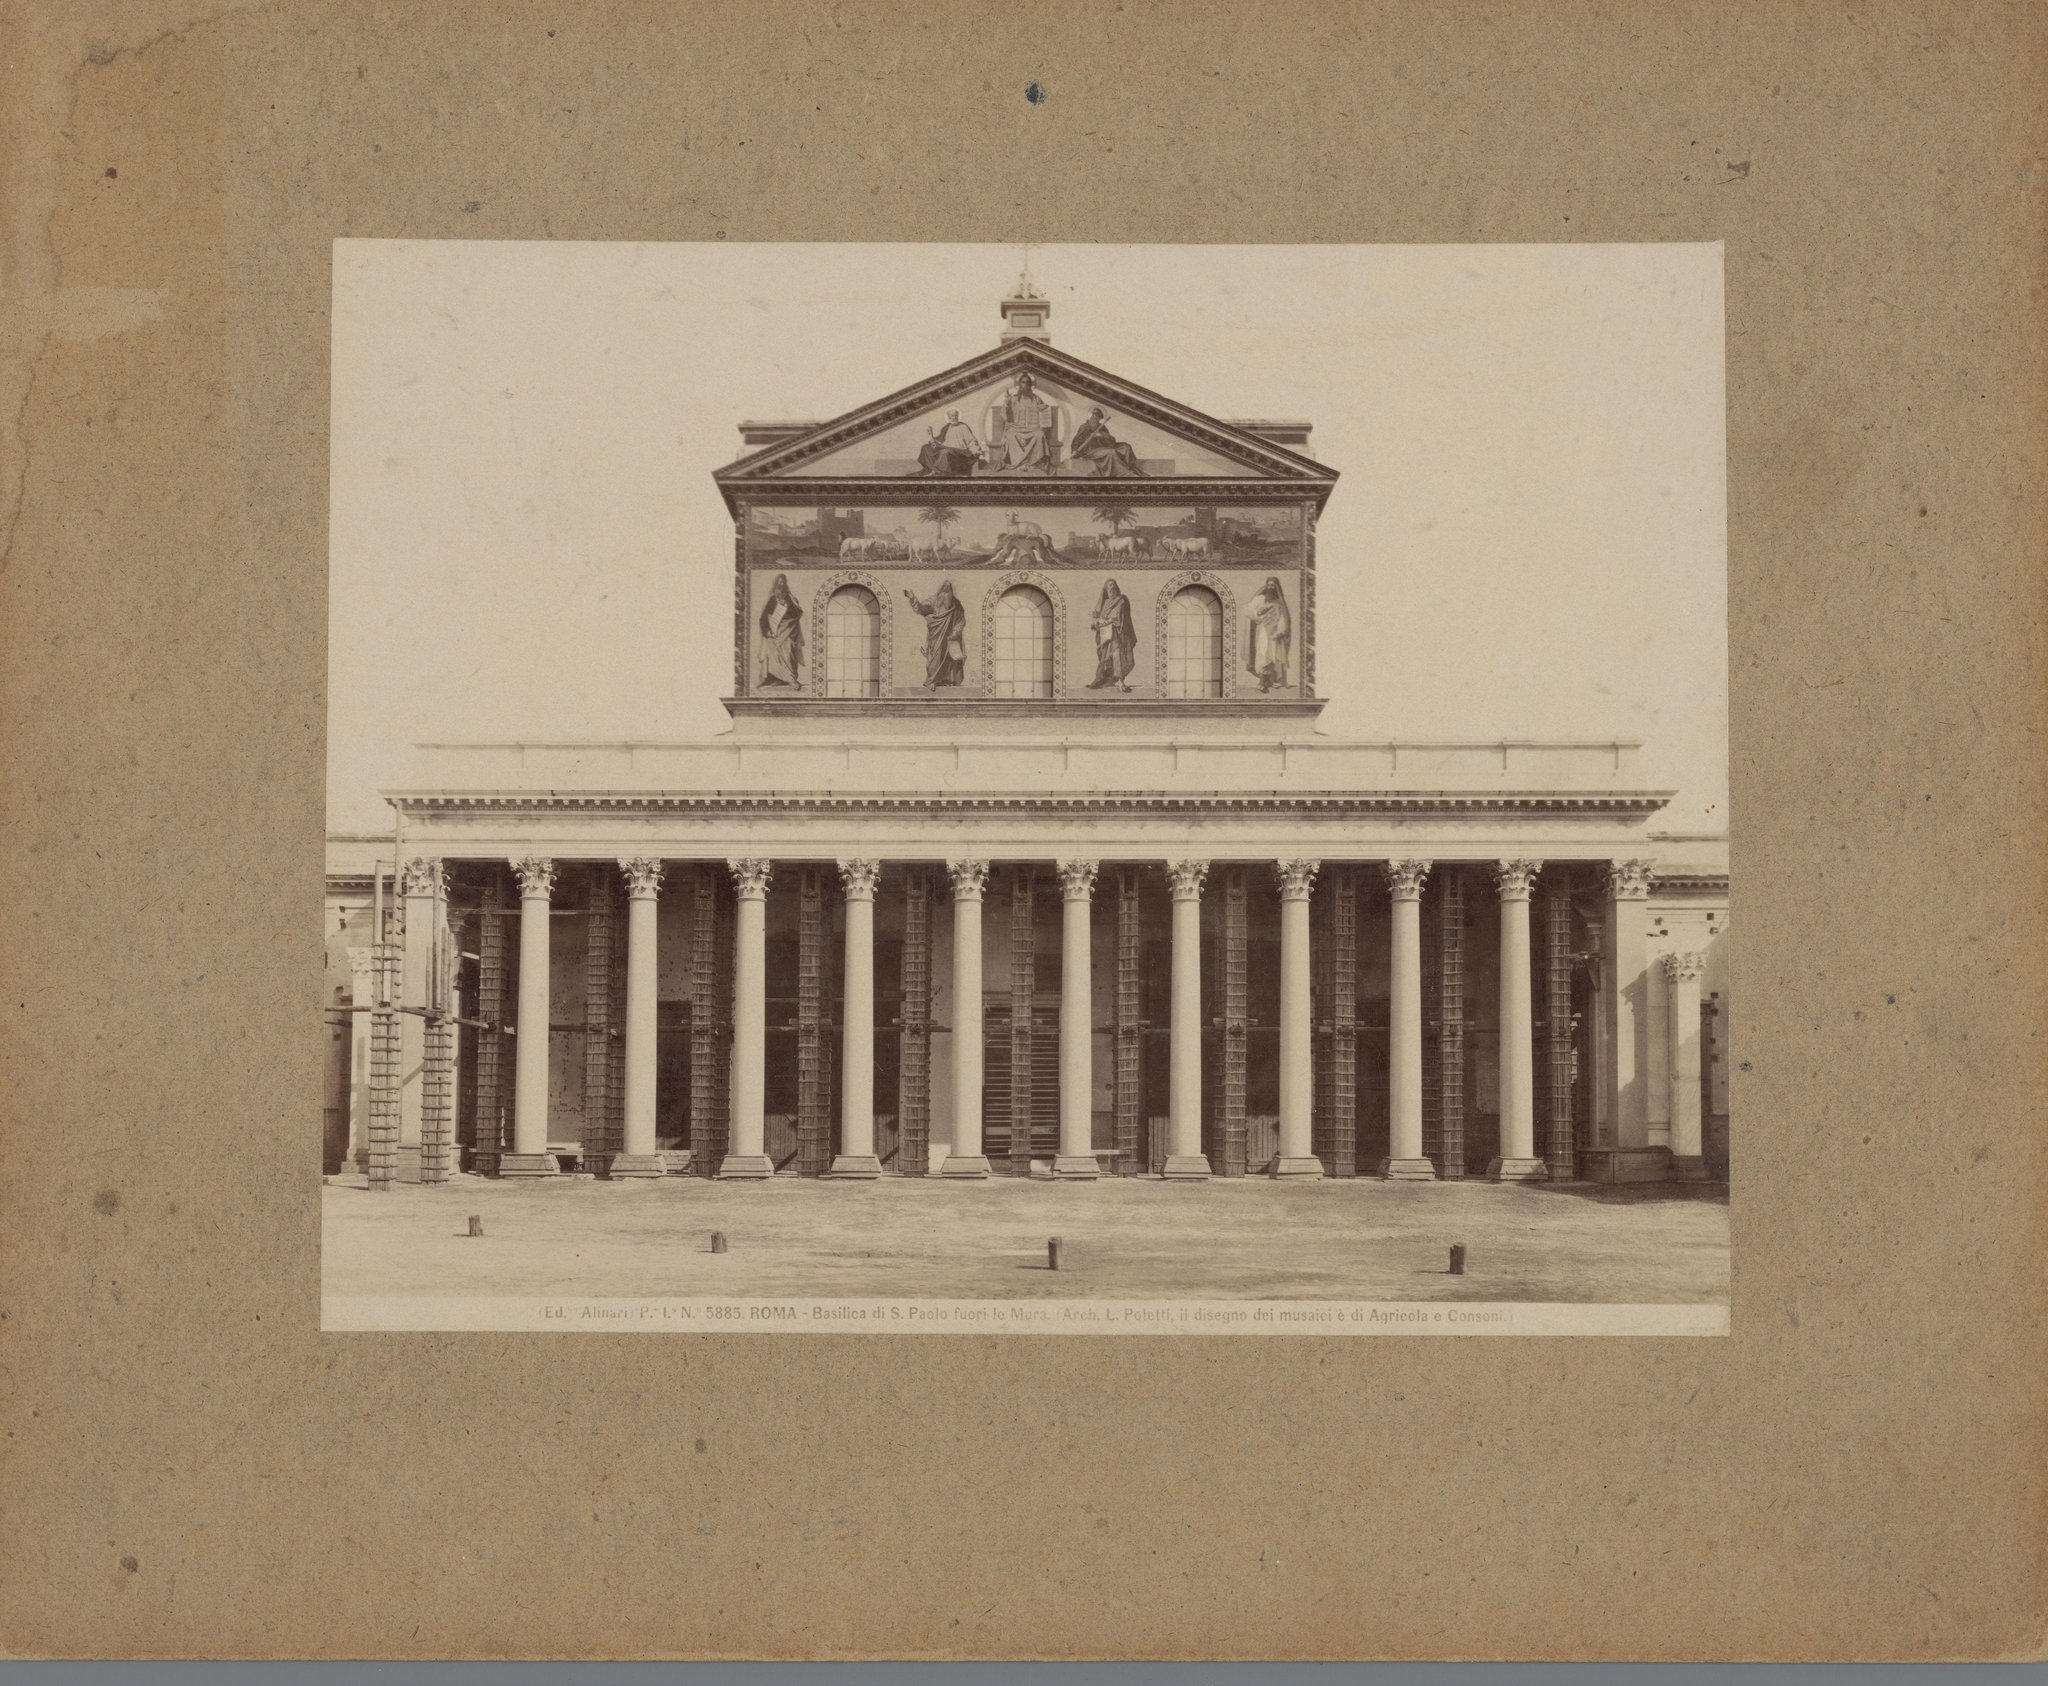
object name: photograph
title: Façade van de Sint-Paulus buiten de Muren te Rome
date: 1875-1900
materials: cardboard, photographic support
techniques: albumen print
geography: rome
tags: church (exterior), façade (of house or building)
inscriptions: collector's mark: Lugt 3937, number: ‘P.e I.a N.o 5885.’